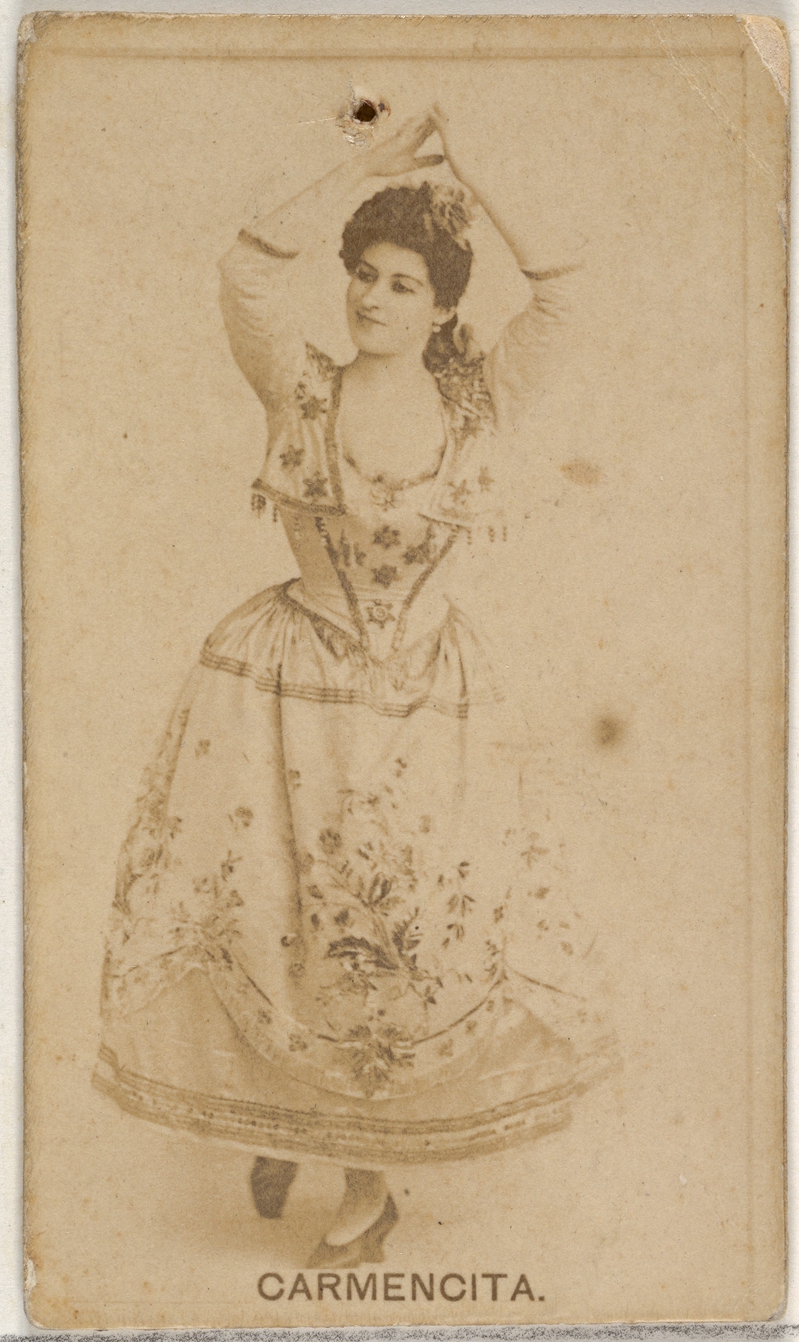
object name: photograph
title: Carmencita, from the Actors and Actresses series (N45, Type 8) for Virginia Brights Cigarettes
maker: allen & ginter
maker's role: publisher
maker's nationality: american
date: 1888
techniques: albumen silver print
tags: portraits,women,actresses